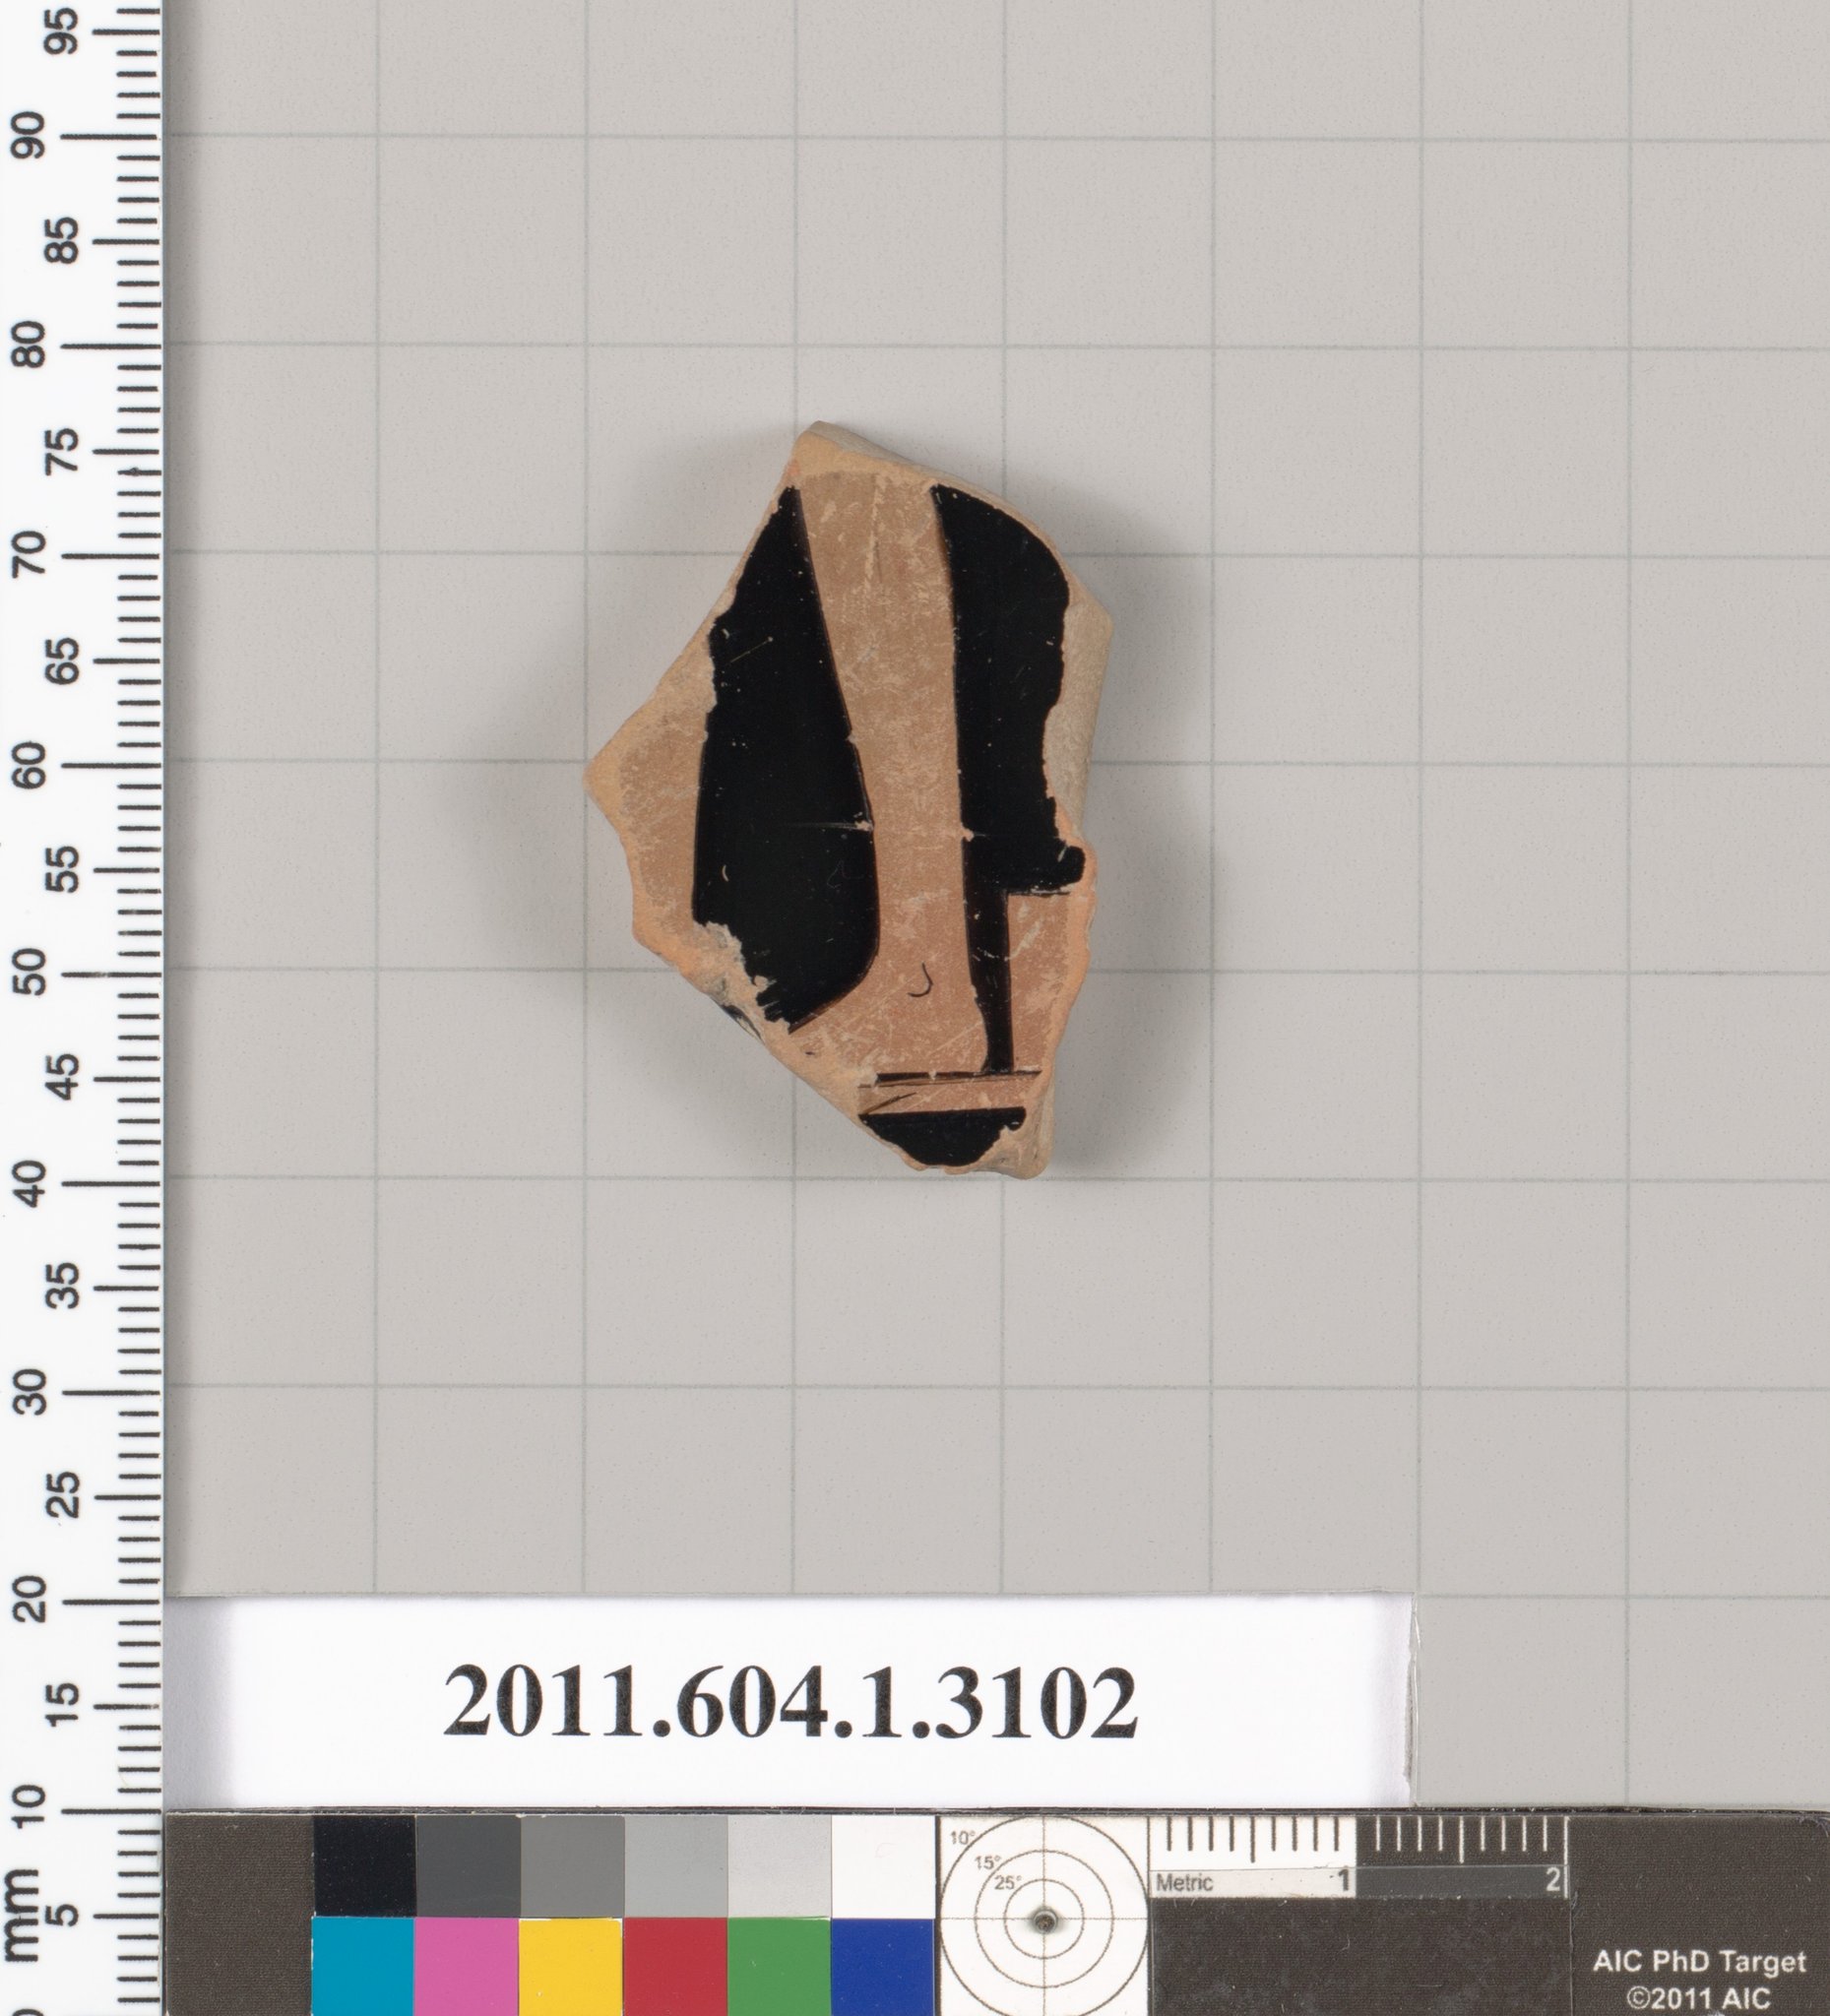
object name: kylix fragment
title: Terracotta fragment of a kylix (drinking cup)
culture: greek, attic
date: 500-470 BCE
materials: terracotta